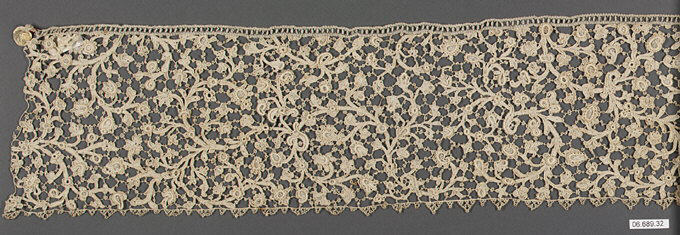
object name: border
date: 1667-1733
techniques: lace